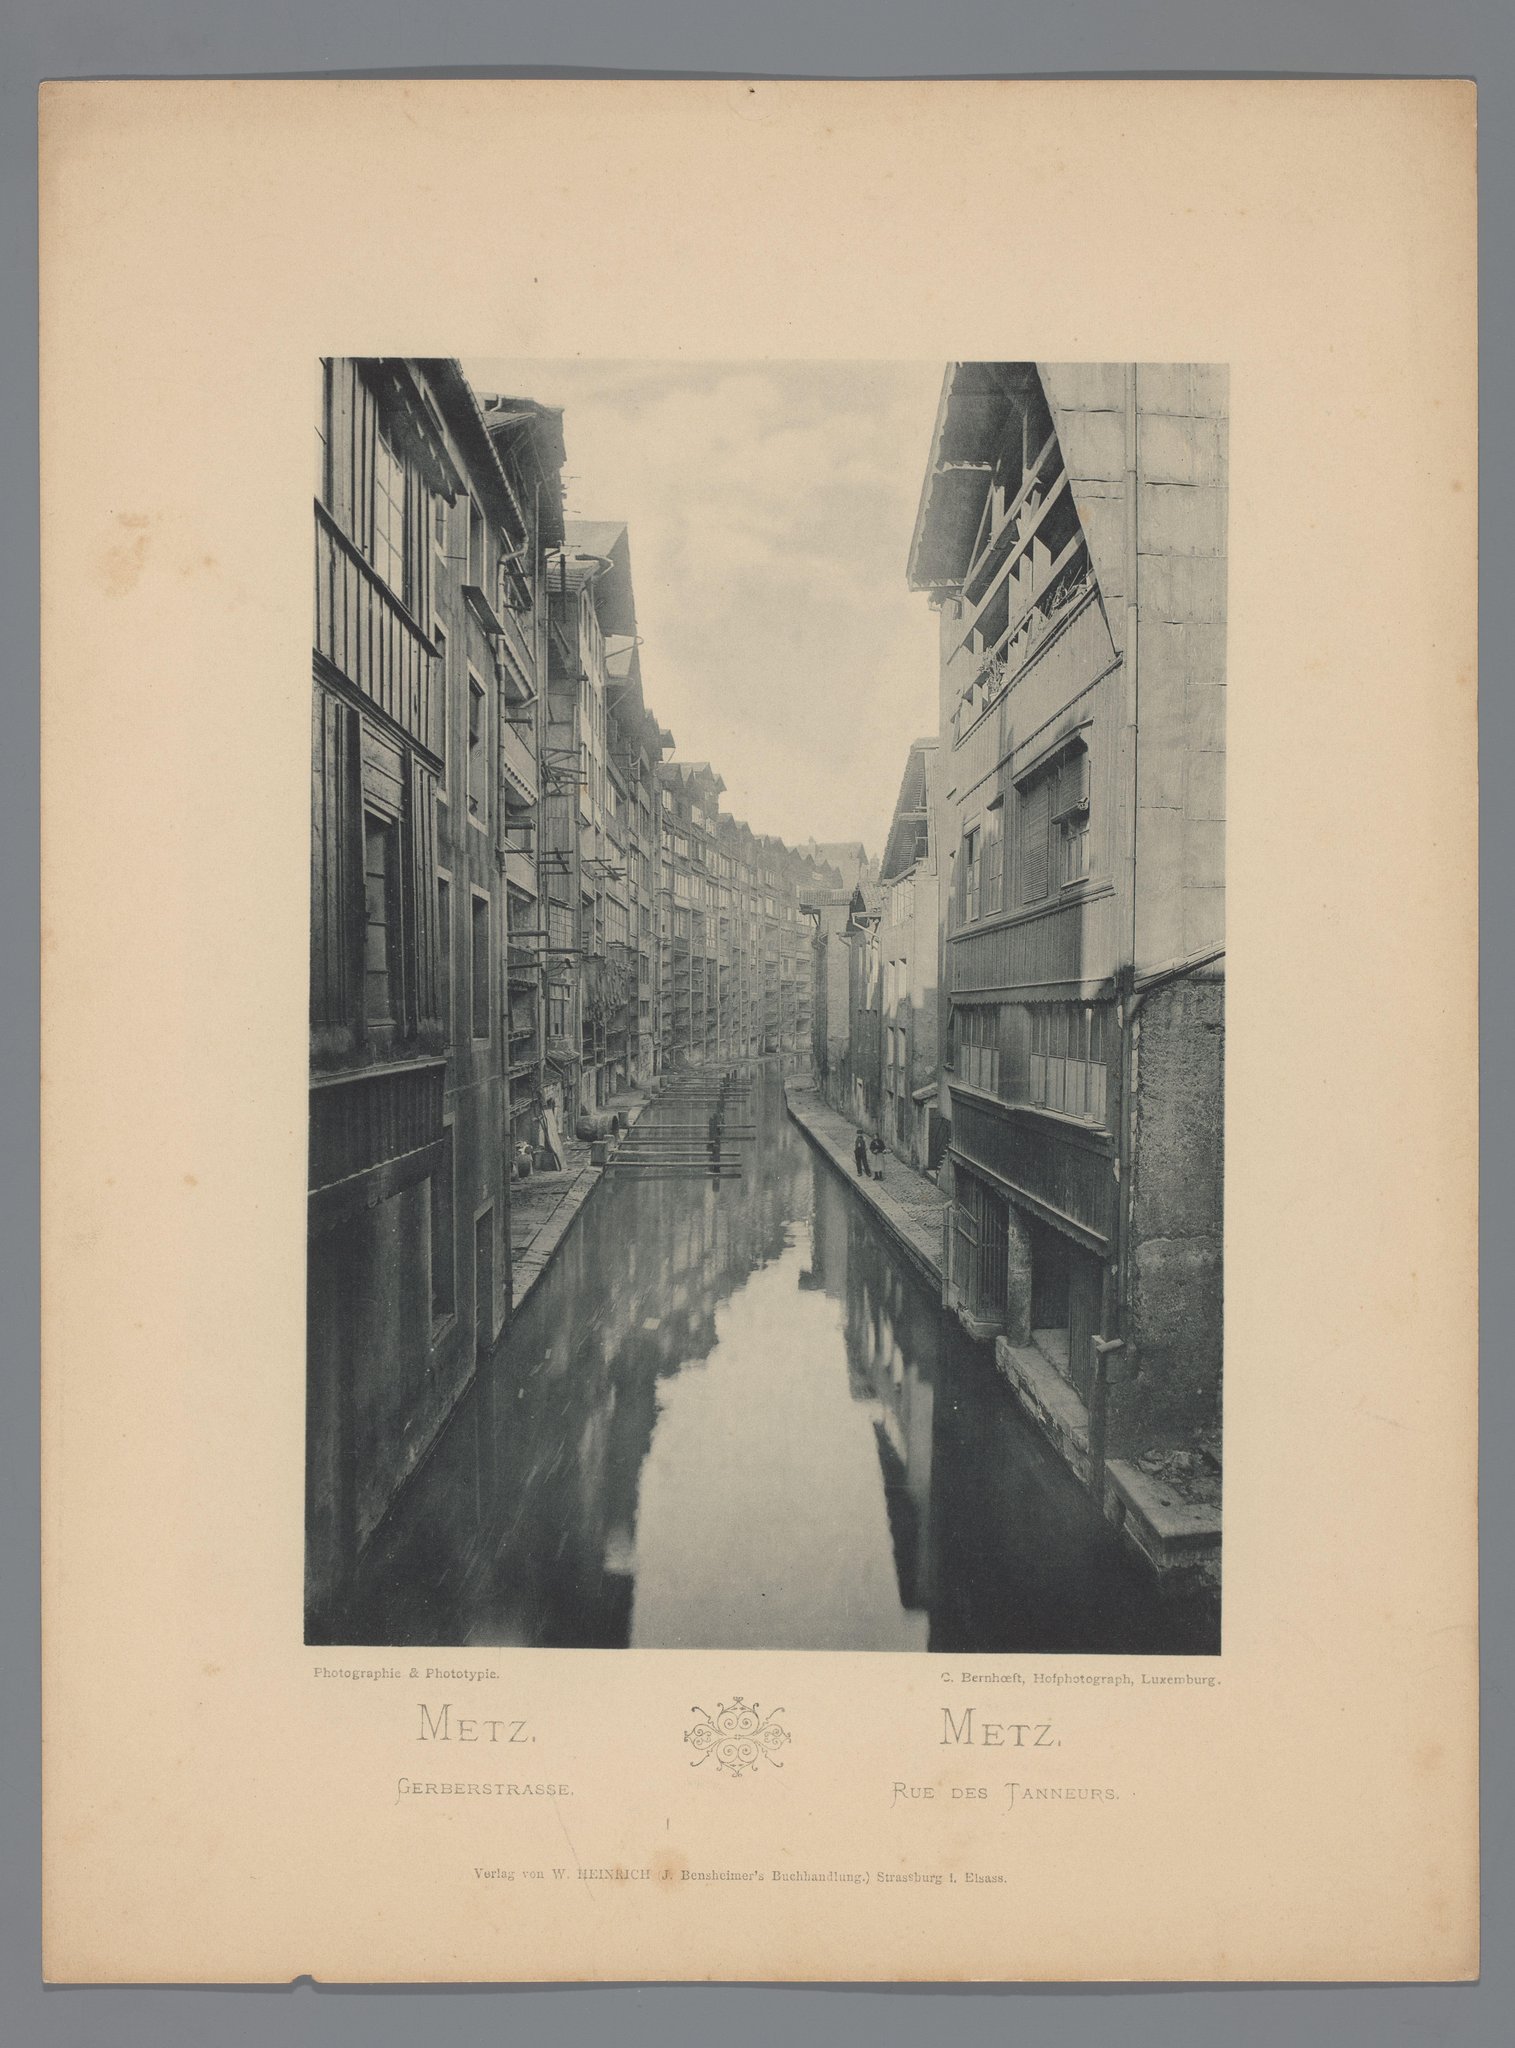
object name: photomechanical print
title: Gezicht de Rue des Tanneurs te Metz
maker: charles bernhoeft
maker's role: publisher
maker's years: 1859-1933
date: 1889-1894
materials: paper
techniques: photograph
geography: metz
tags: urban housing, canals, waters (in city), street (+ city(-scape) with figures, staffage)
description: Deze prent maakt deel uit van een omslag met 100 prenten.